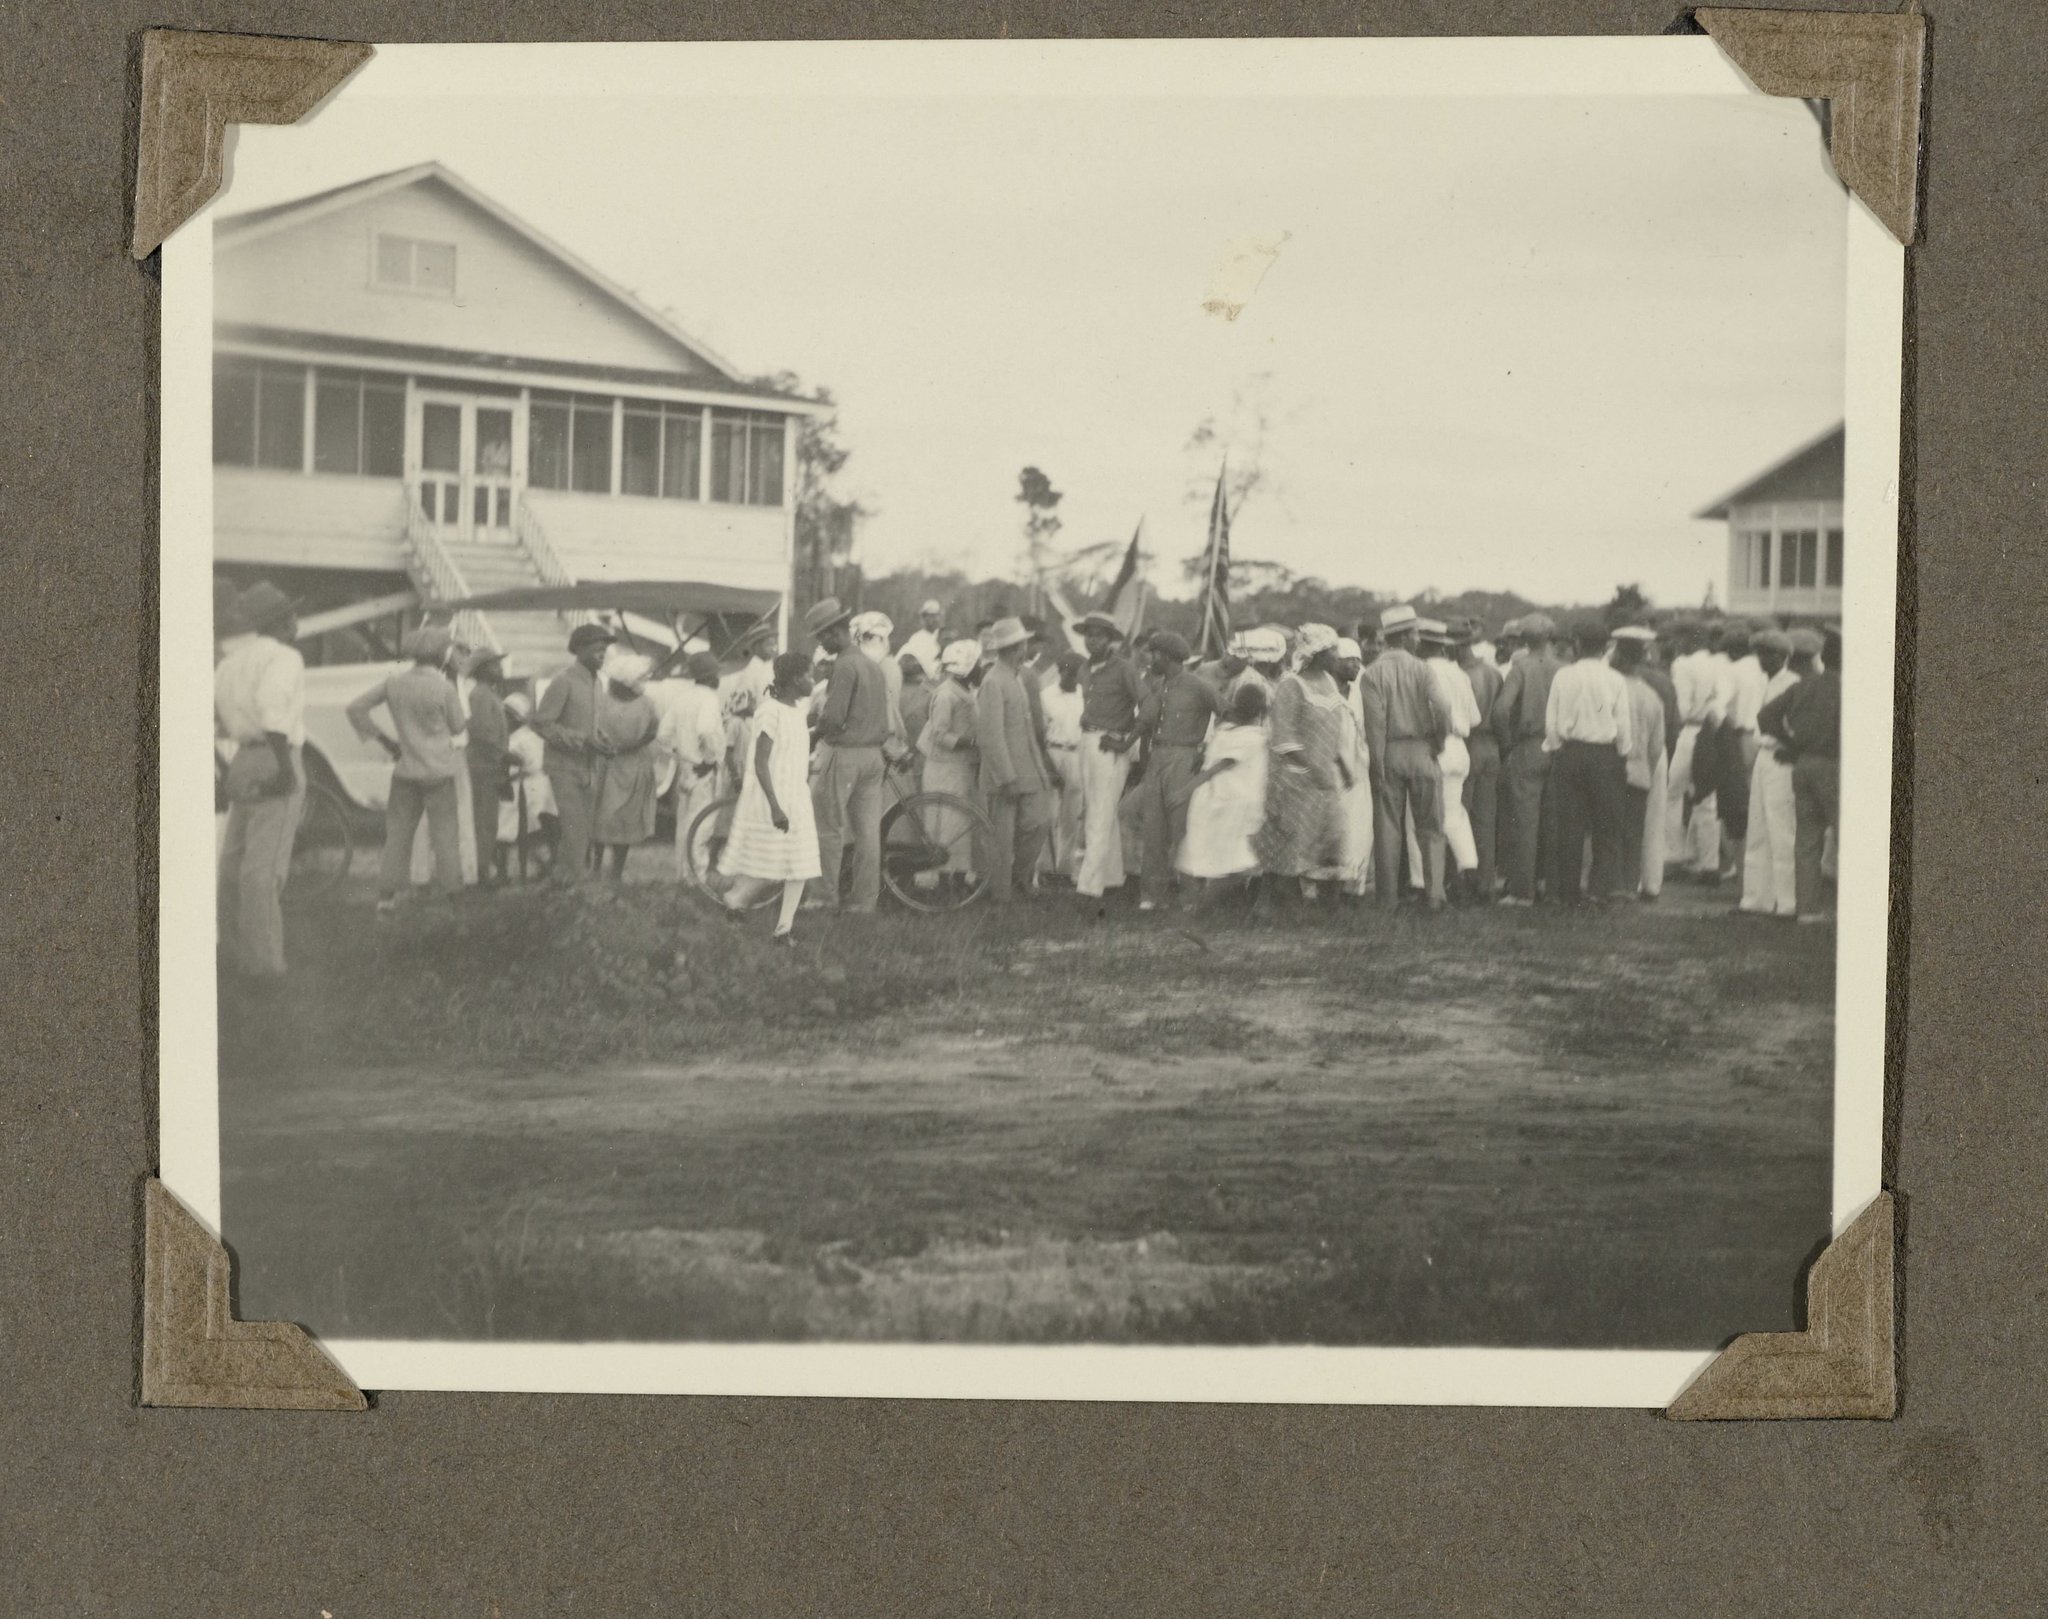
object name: photograph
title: Bijeenkomst van een groep Surinamers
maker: Anonymous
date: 1925-1927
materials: photographic support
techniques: photography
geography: suriname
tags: crowd, mob, suriname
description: Bijeenkomst van een groep Surinamers met vlaggen voor een huis. Foto met hoekjes bevestigd op een bladzijde van een albumblad in het fotoalbum over de familie Jetten en het leven en werken in de mijnstad Moengo in Suriname rond 1927.